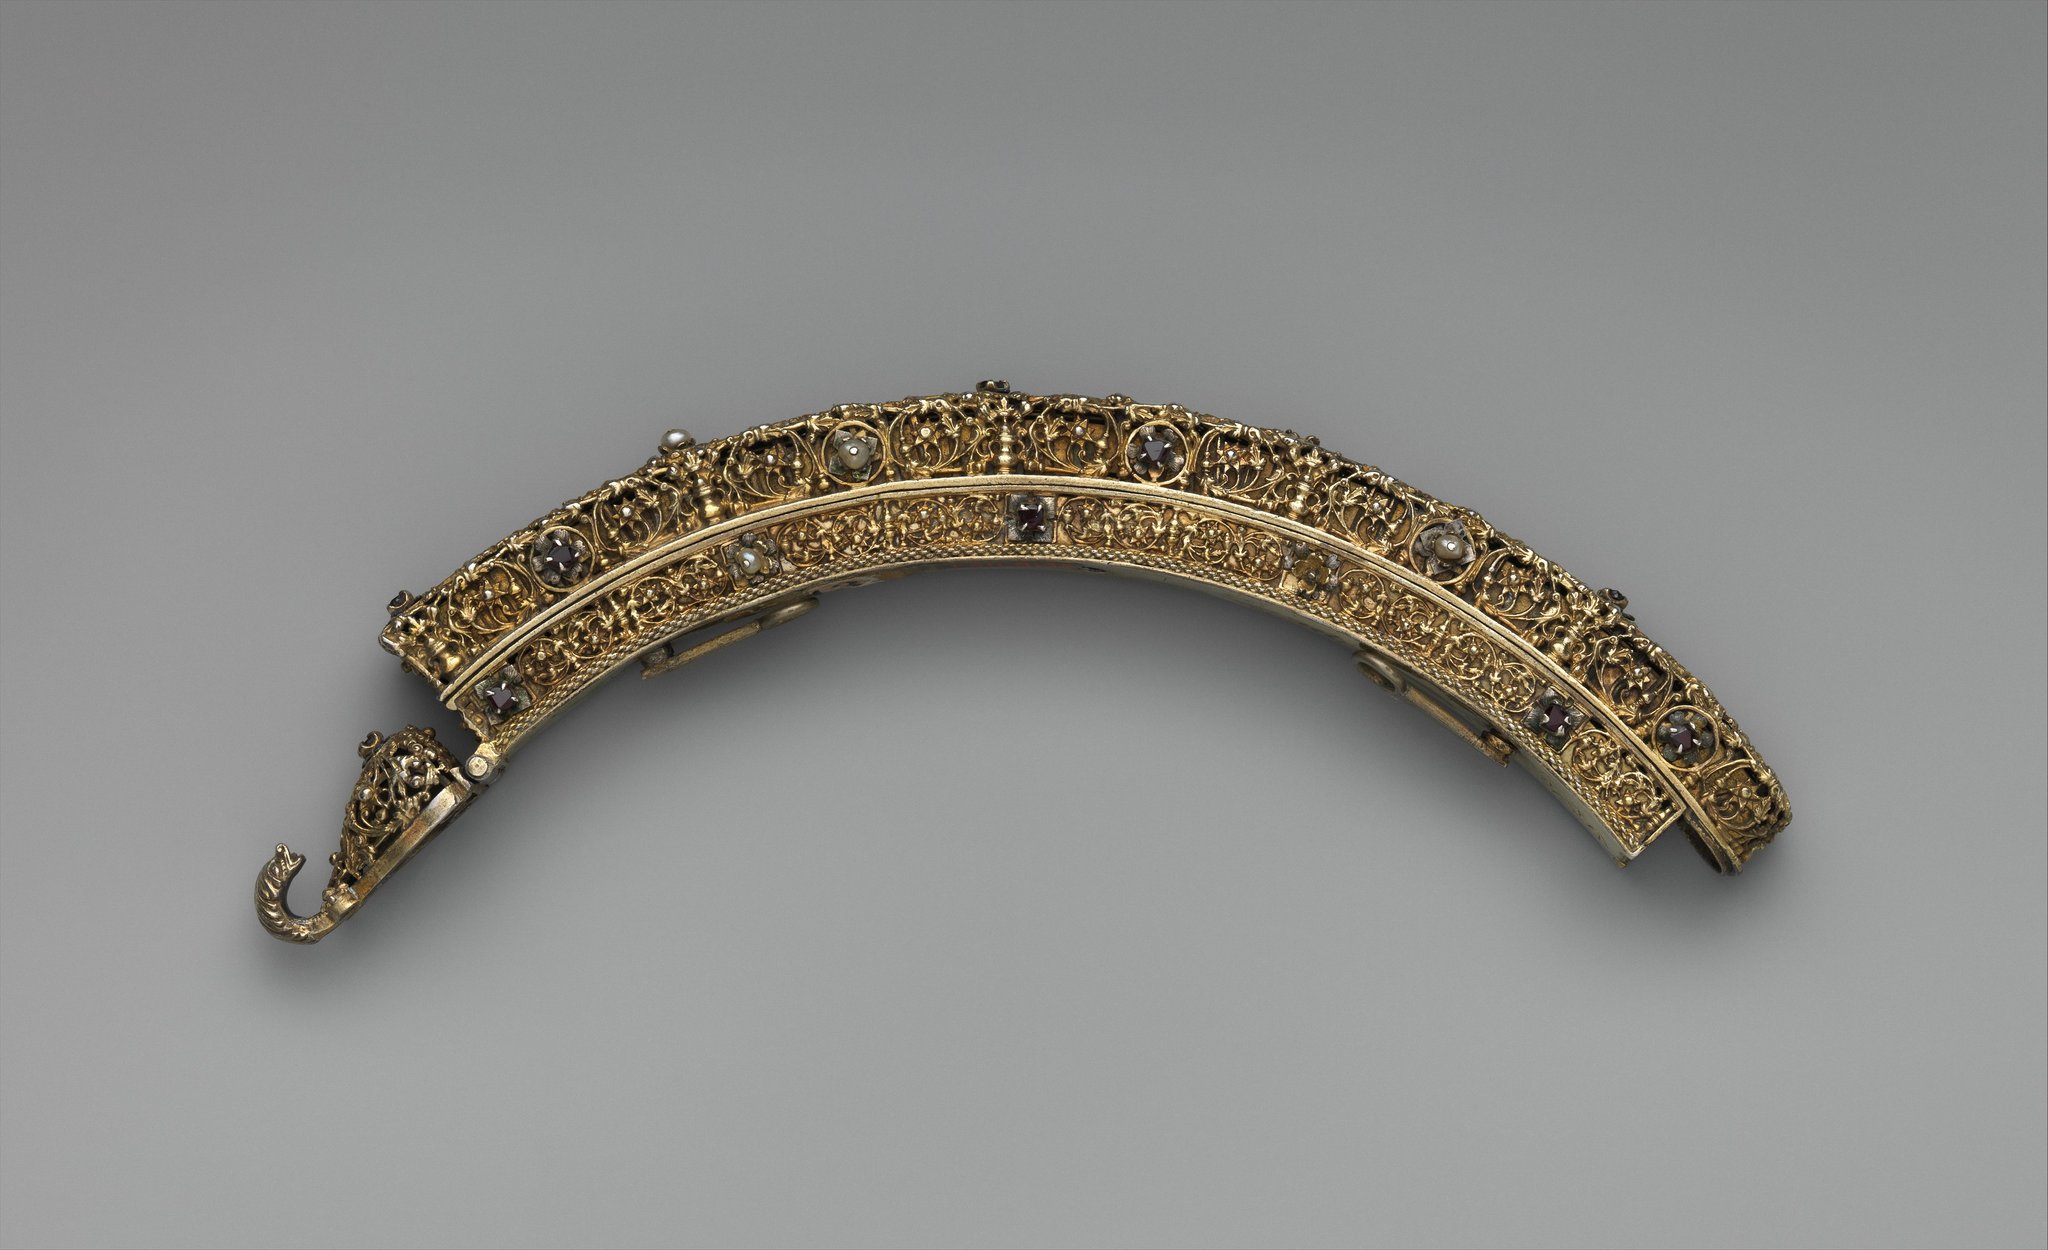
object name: belt buckle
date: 1501-1600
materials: pearl, gemstone, silver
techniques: gilding